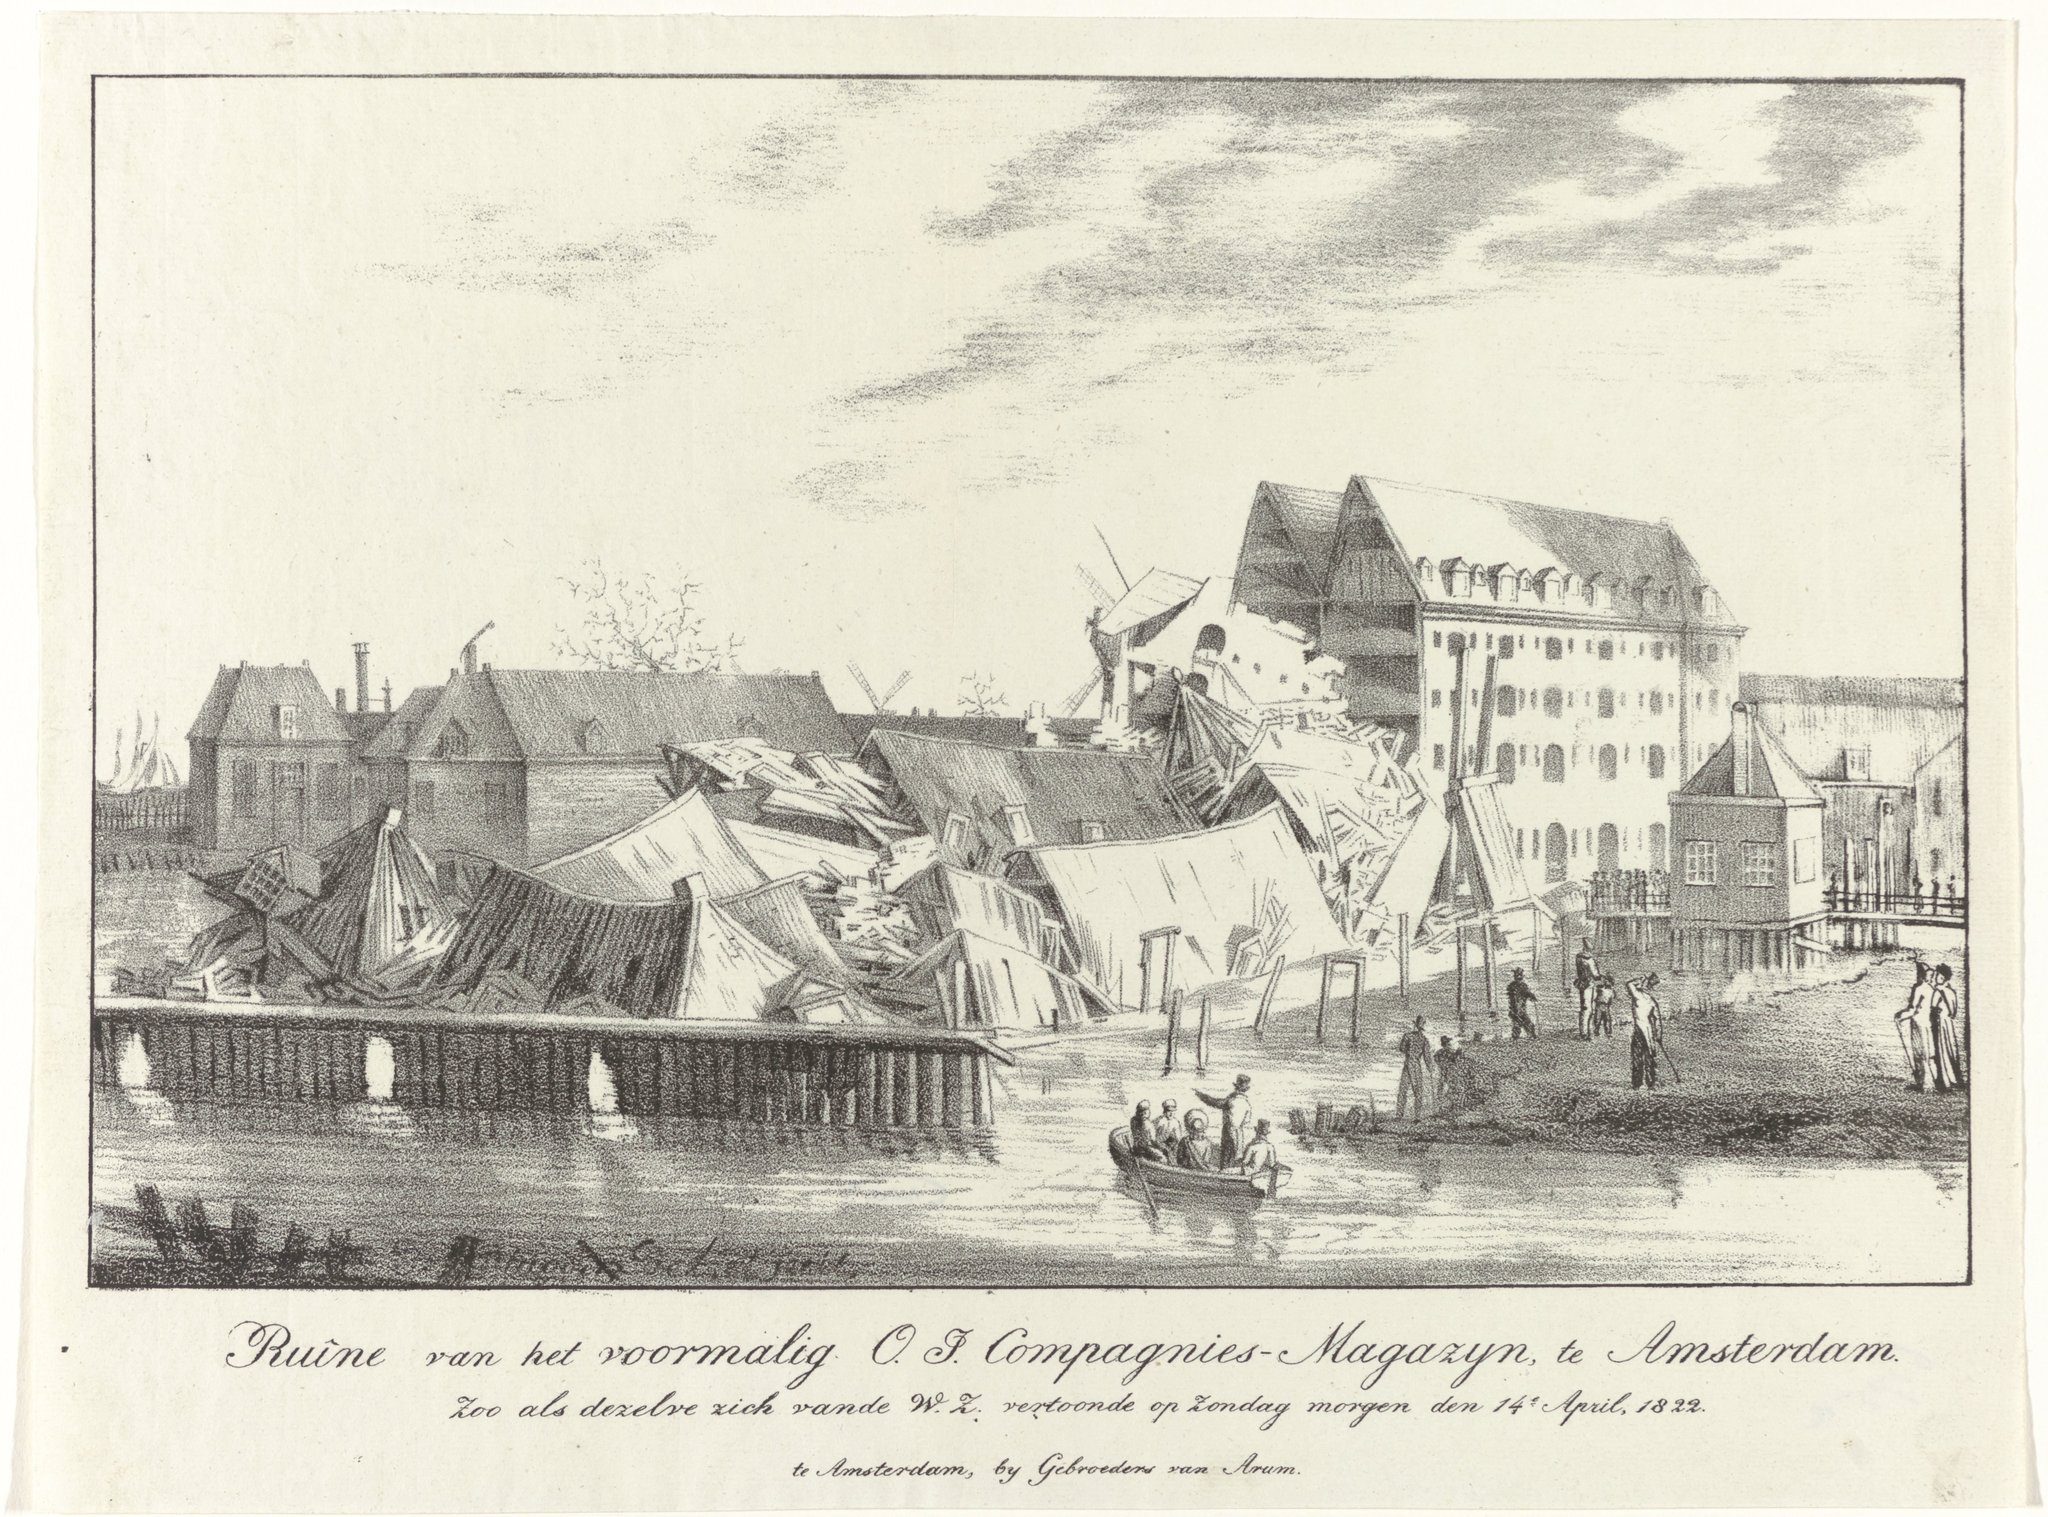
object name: print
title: Ruine van het voormalig O.I. Compagnies-Magazyn, te Amsterdam. Zoo als dezelve zich vande w.z. vertoonde op Zondag morgen den 14e April, 1822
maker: jacob plügger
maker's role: print maker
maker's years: 1795-1871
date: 1822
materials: paper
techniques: lithograph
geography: amsterdam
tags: ruin of a building ~ architecture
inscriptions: collector's mark: Lugt 2228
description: Ruïne van het Oost-Indisch Zeemagazijn te Amsterdam, na de instorting op 13-14 april 1822. Gezicht van de westzijde. Zie ook de pendant en de bijbehorende afzonderlijke verklaring.